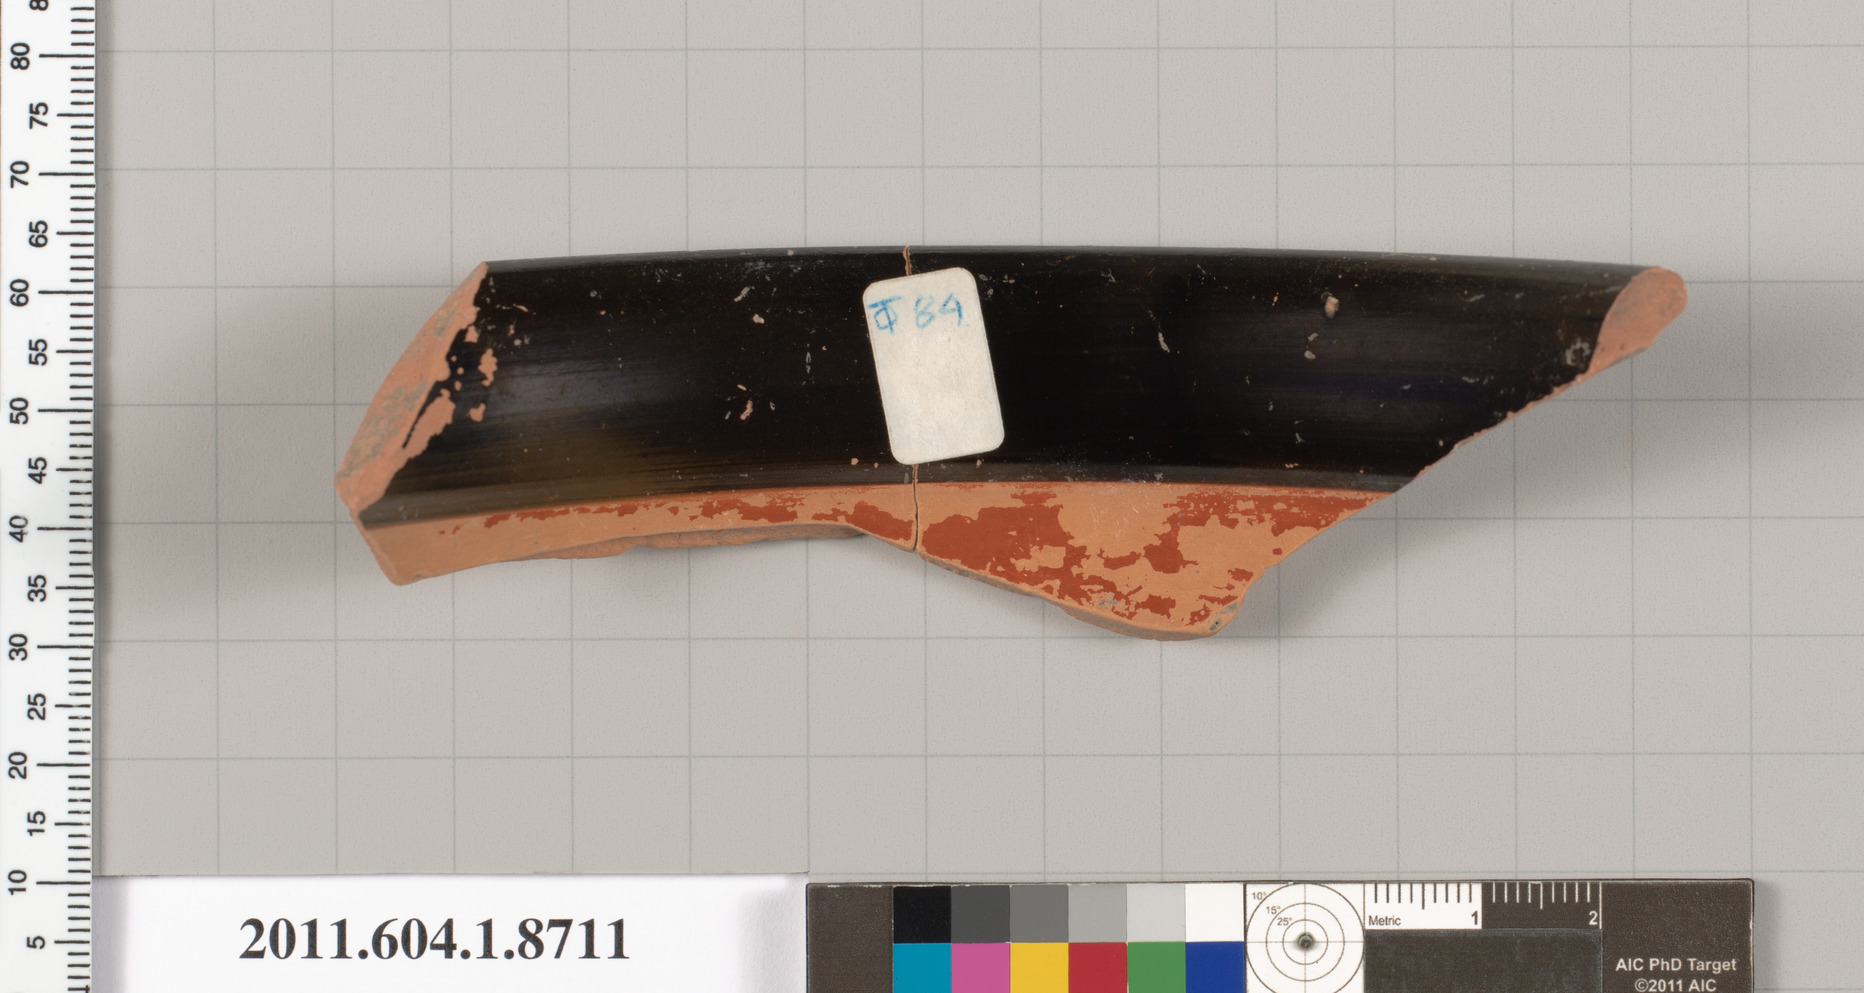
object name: kylix fragment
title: Terracotta fragment of a kylix (drinking cup)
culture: greek, attic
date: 470-450 BCE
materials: terracotta